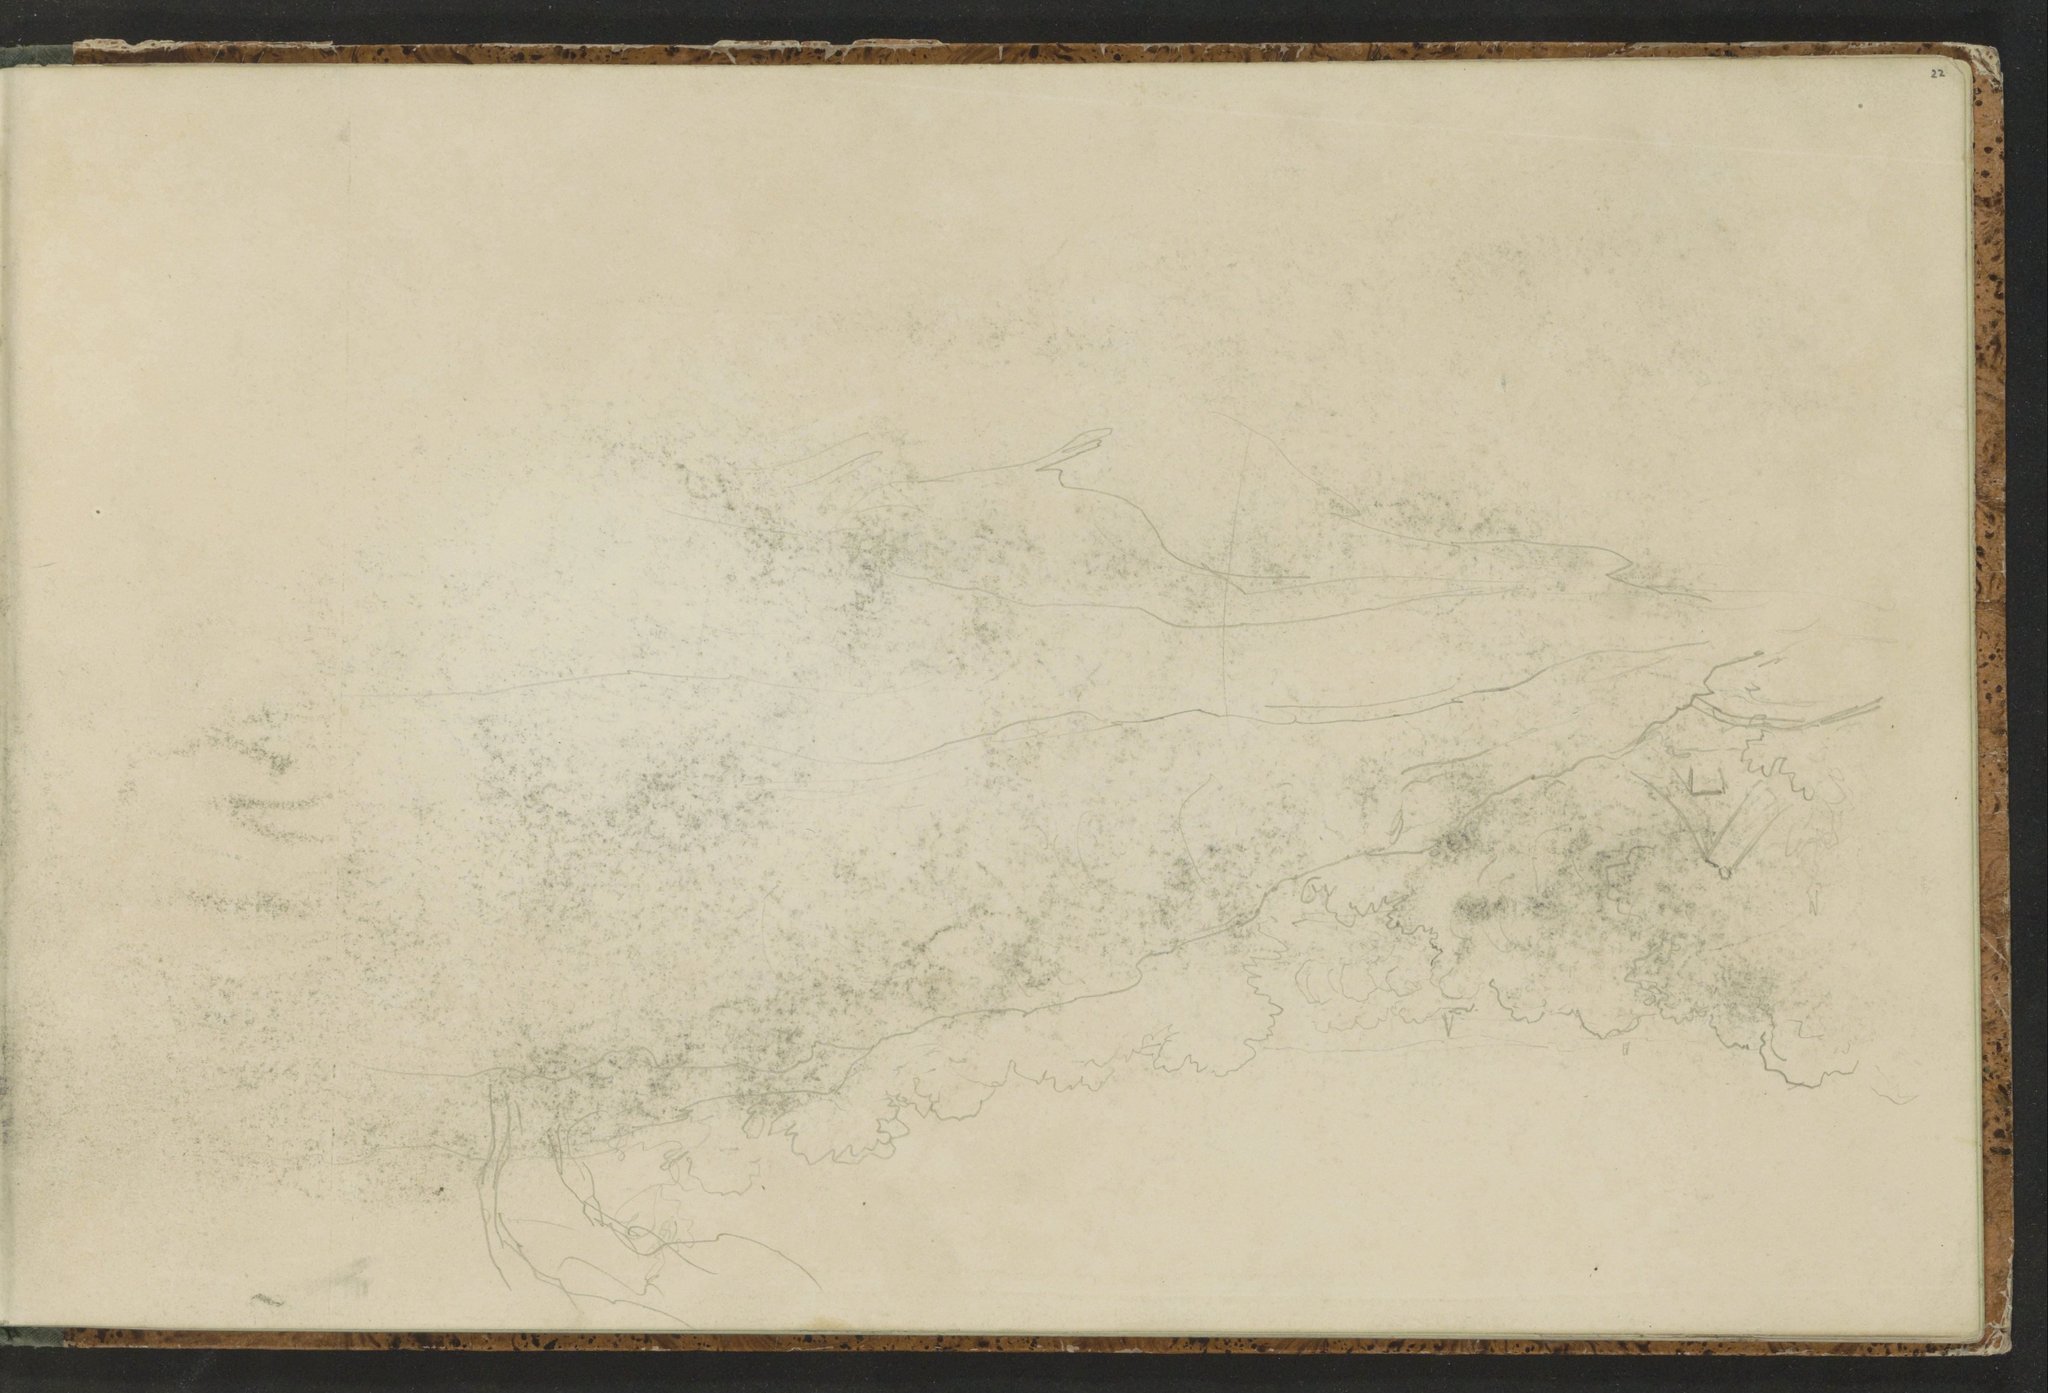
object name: sketchbook leaf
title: Heuvellandschap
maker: johannes tavenraat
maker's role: draughtsman, painter, print maker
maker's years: 1809-1881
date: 1840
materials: paper, pencil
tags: low hill country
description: Blad 22 recto uit een schetsboek met 33 bladen.